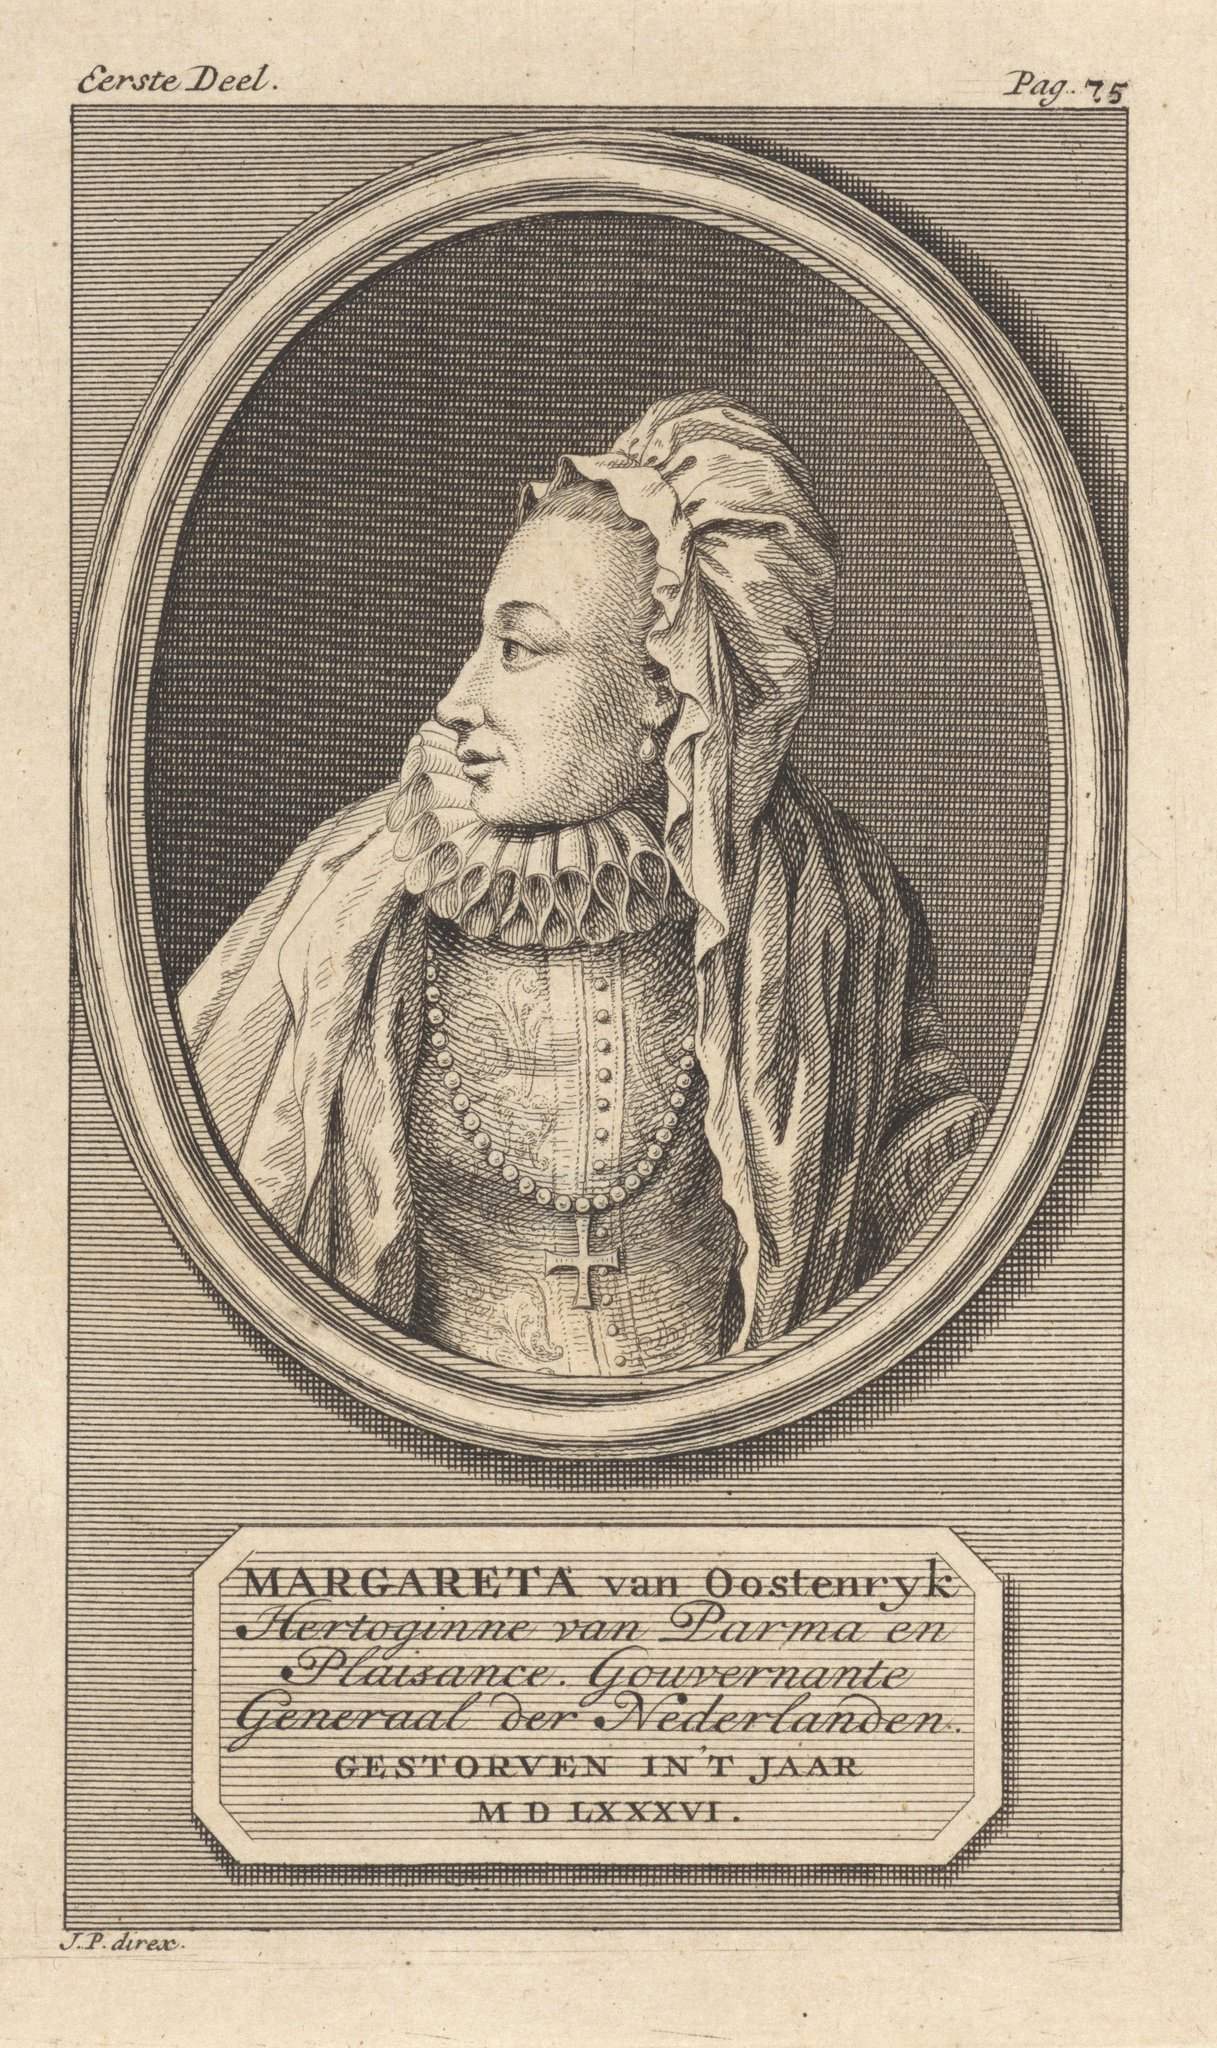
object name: print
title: Portret van Margaretha van Parma, landvoogdes der Nederlanden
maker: jan punt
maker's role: draughtsman, print maker, publisher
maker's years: 1711-1779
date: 1748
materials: paper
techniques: engraving, etching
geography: northern netherlands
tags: oudenaarde, landvoogd, landvoogdes der nederlanden margaretha van parma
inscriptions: collector's mark: Lugt 2228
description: Illustratie uit: Meteren, Emanuel van. Historie van de oorlogen en geschiedenissen der Nederlanderen, en der zelver naburen: beginnende met den jare 1315, en eindigende met den jare 1611, deel I, p. 200. Gorinchem/Breda: Nicolaas Goetzee, Pieter Goetzee/Willem Goetzee, 1748.